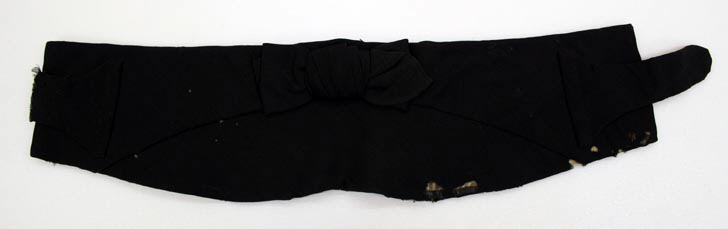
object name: stock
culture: british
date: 1830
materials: leather, silk, wool